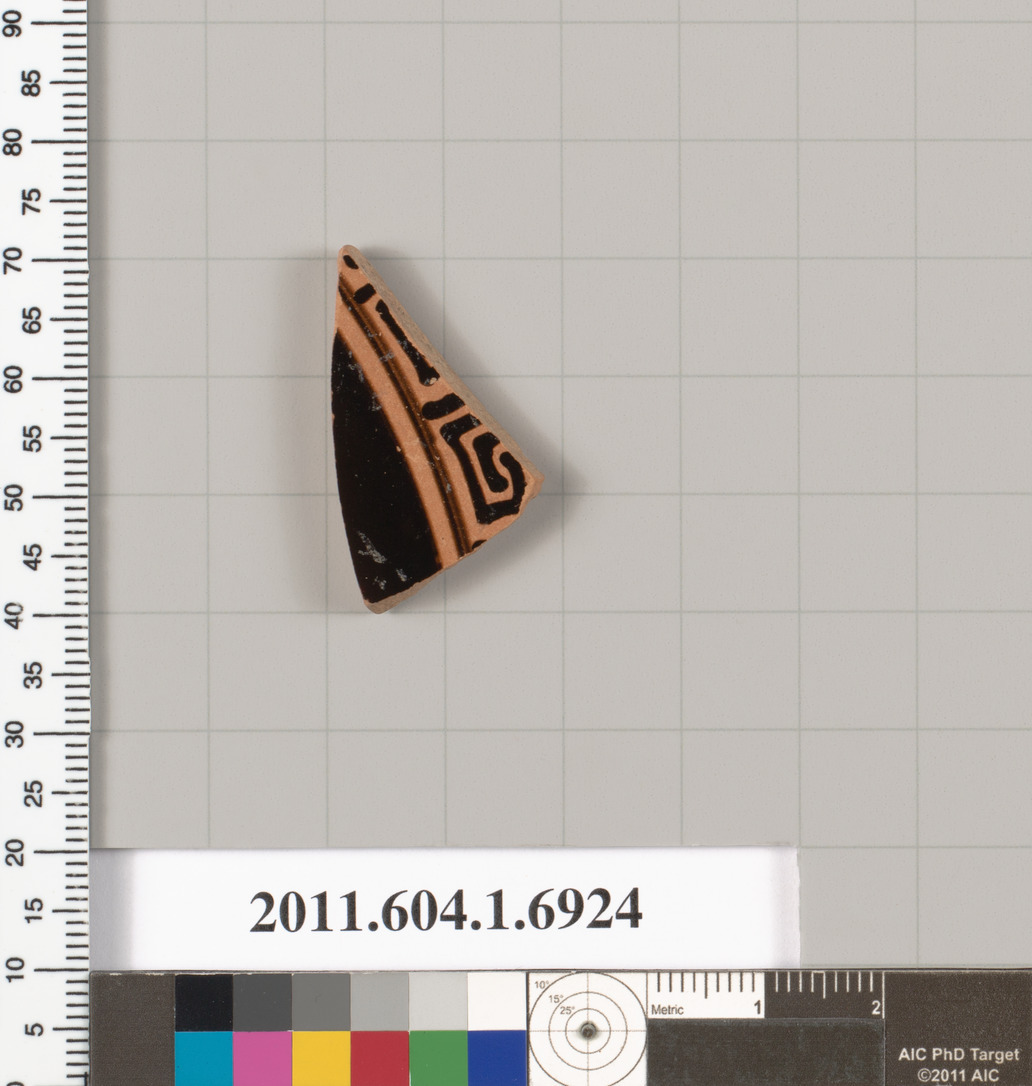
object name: kylix fragment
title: Terracotta fragment of a kylix (drinking cup)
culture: greek, attic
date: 490-470 BCE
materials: terracotta